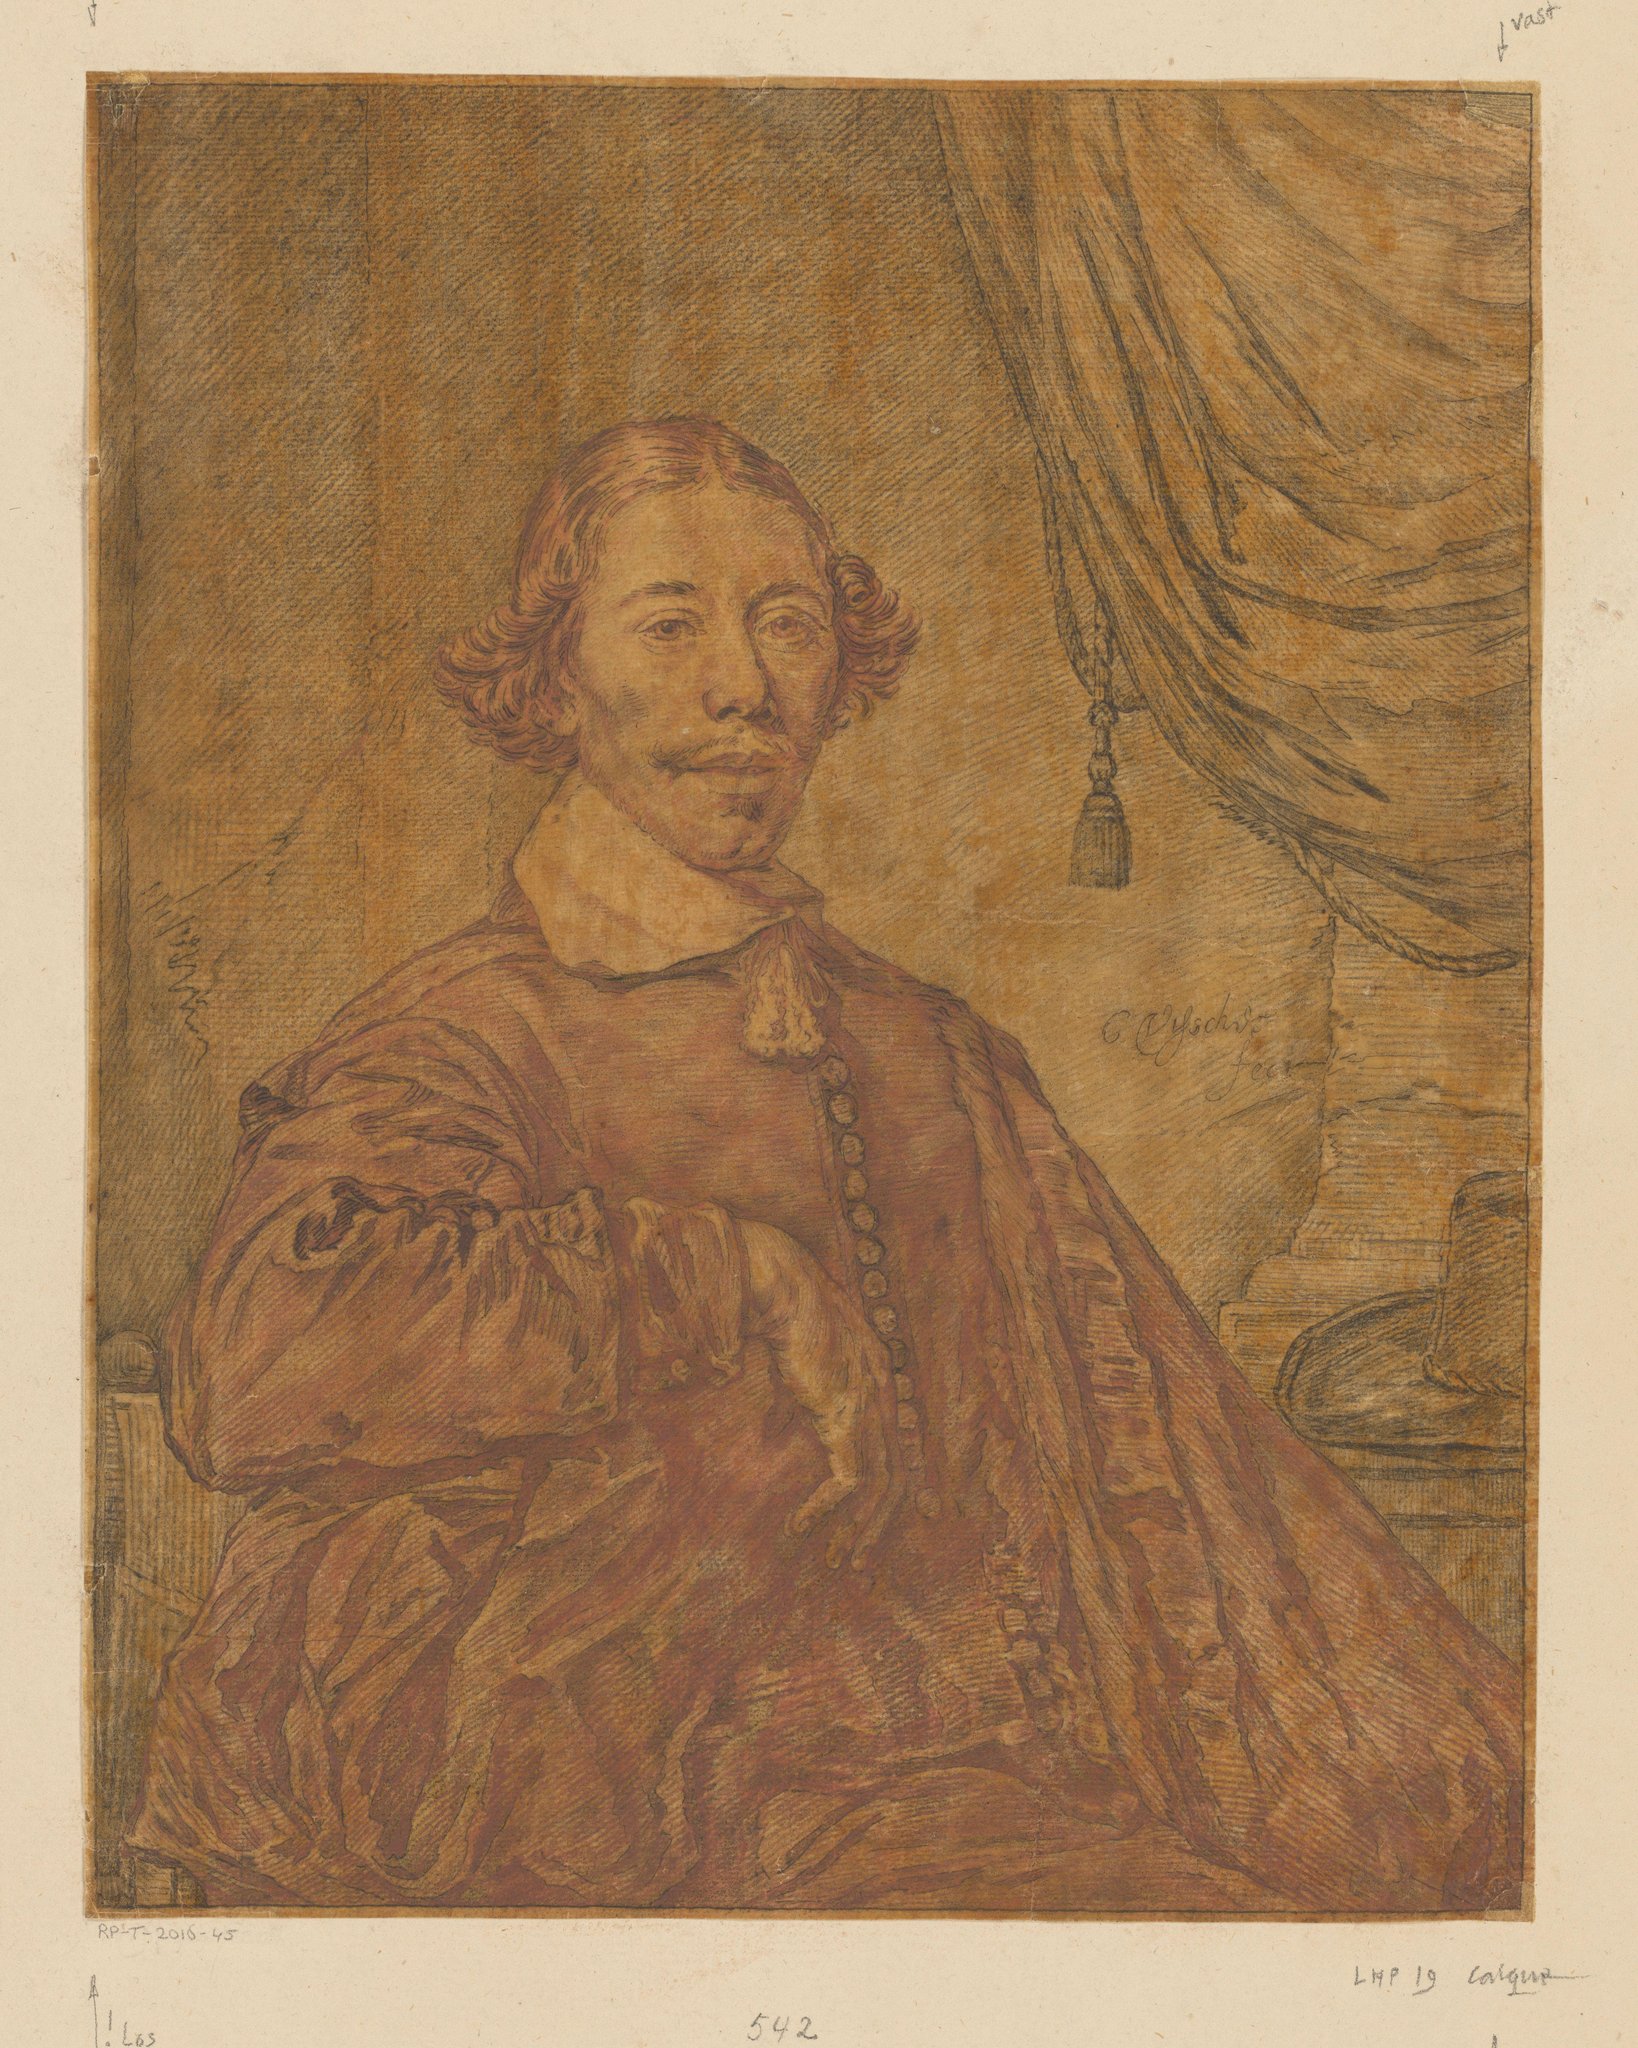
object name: tracing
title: Portret van een man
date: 1766-1770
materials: chalk, ink, paper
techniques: brush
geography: amsterdam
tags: adult man, head-gear: hat (+ men's clothes)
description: Portret van een man, zittend voor een gordijn. Zijn hoed ligt op een tafel. De calque ligt los in een album, zie blad 19.